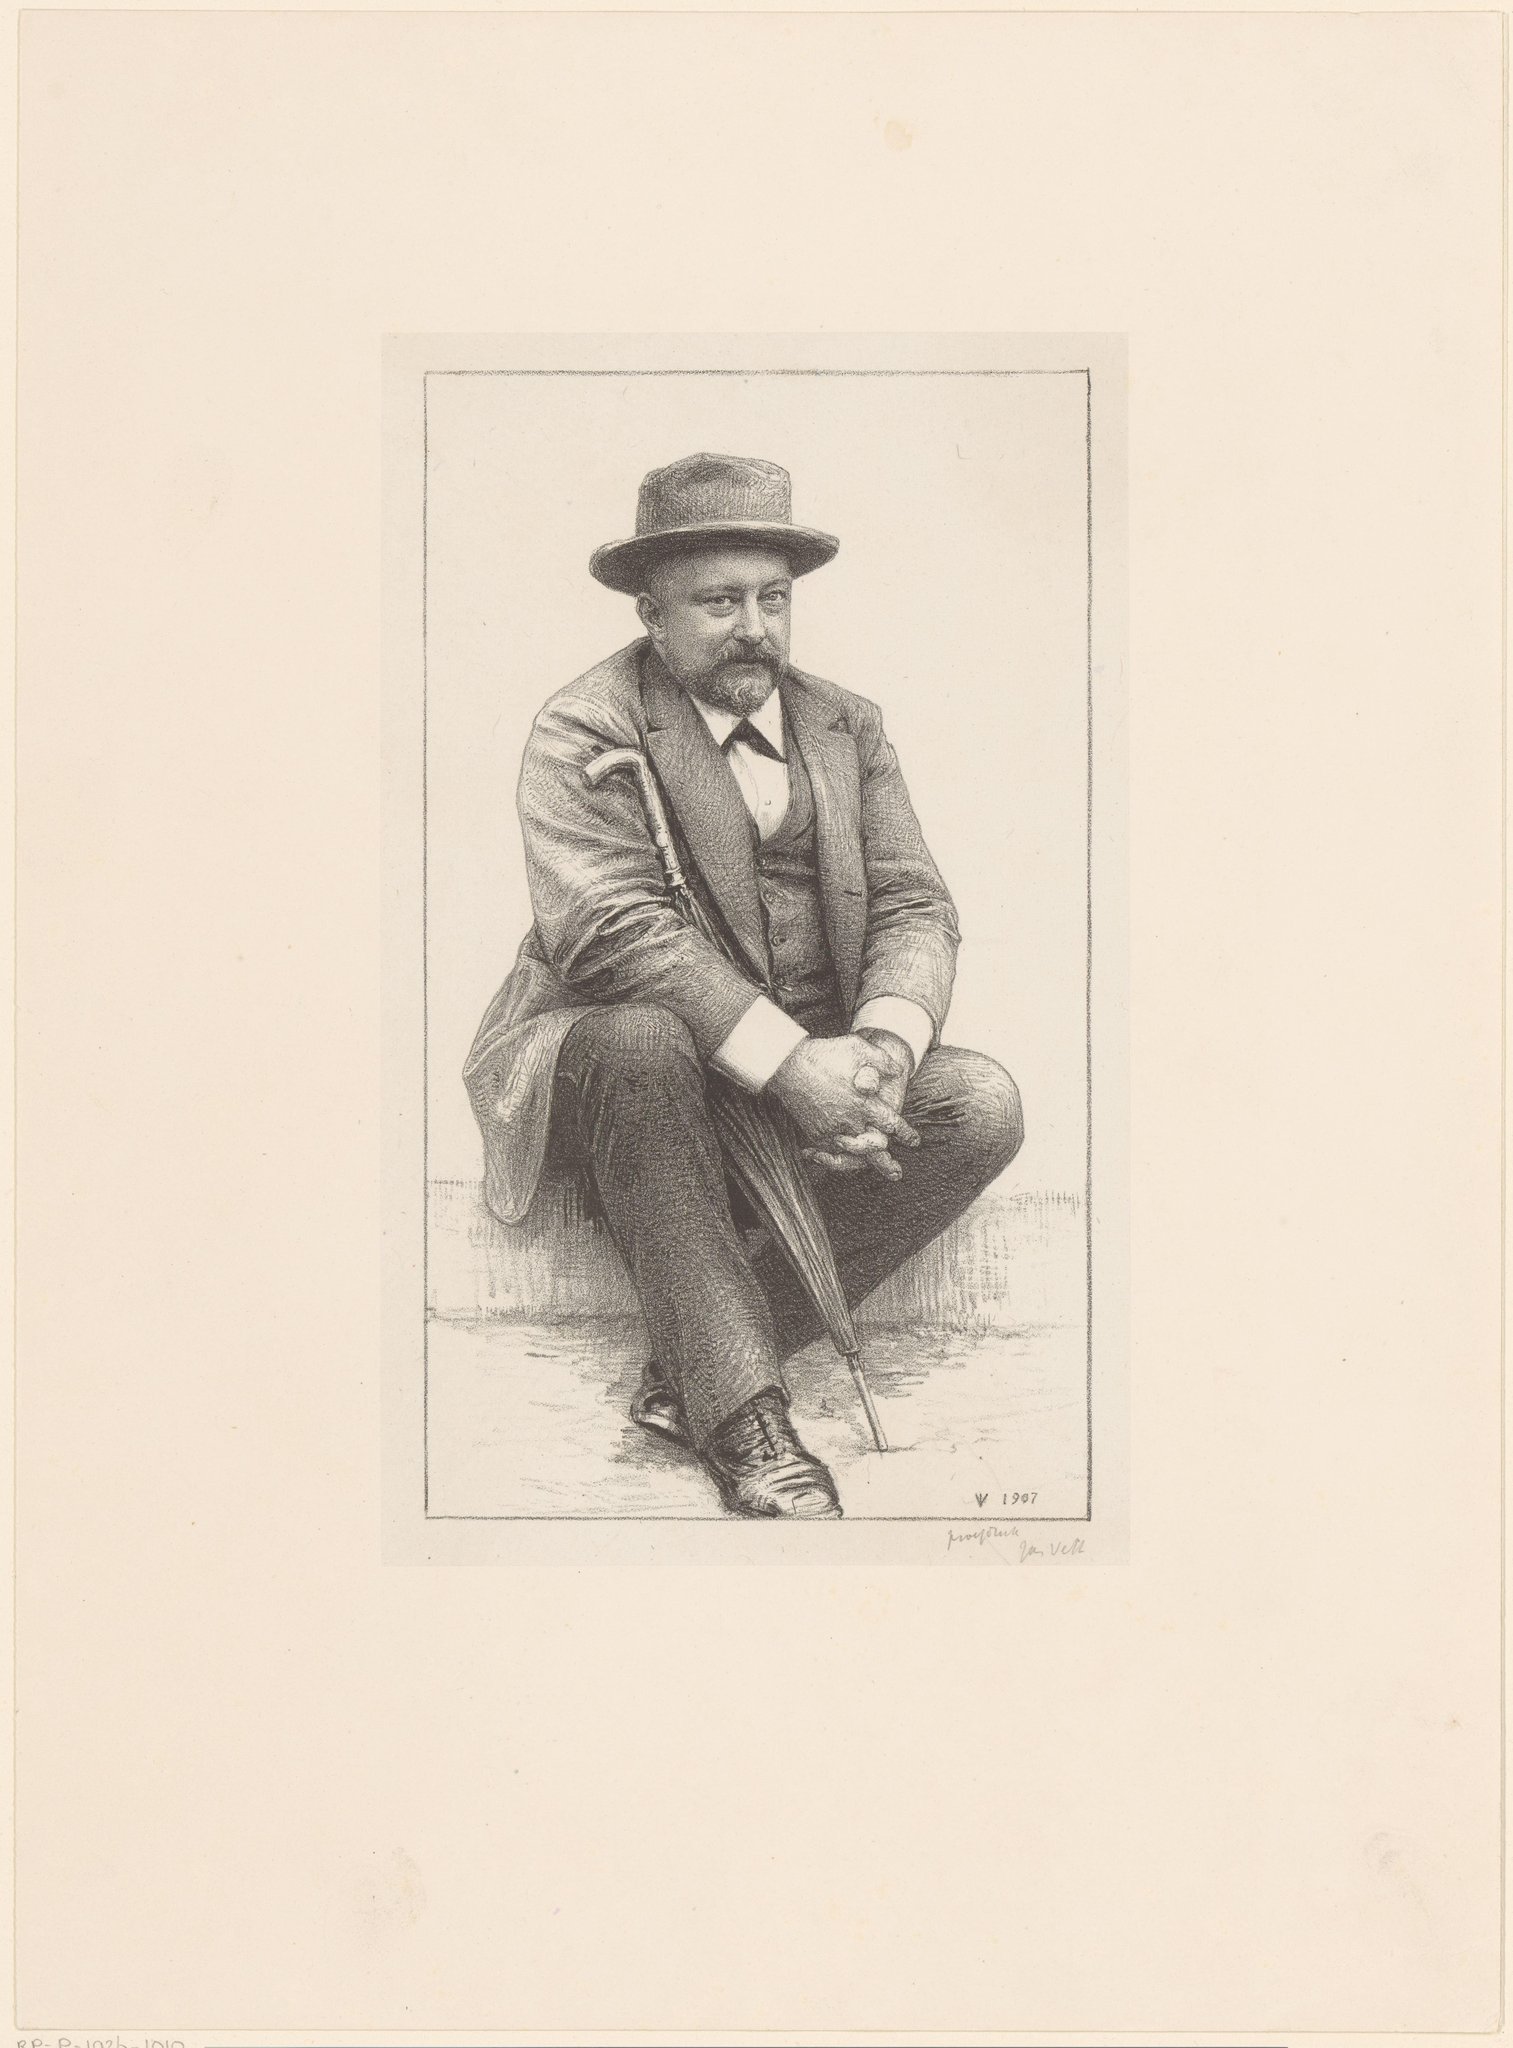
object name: print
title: Portret van Pieter Lodewijk Tak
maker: jan veth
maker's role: designer, draughtsman, painter, print maker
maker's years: 1864-1925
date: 1907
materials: paper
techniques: lithograph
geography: netherlands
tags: middelburg, politician, pieter lodewijk tak, historical persons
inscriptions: collector's mark: Lugt 2228, inscription: ‘proefdruk / Jan Veth’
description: Dit portret werd uitgegeven als bijvoegsel bij De Kroniek op 19 oktober 1907.